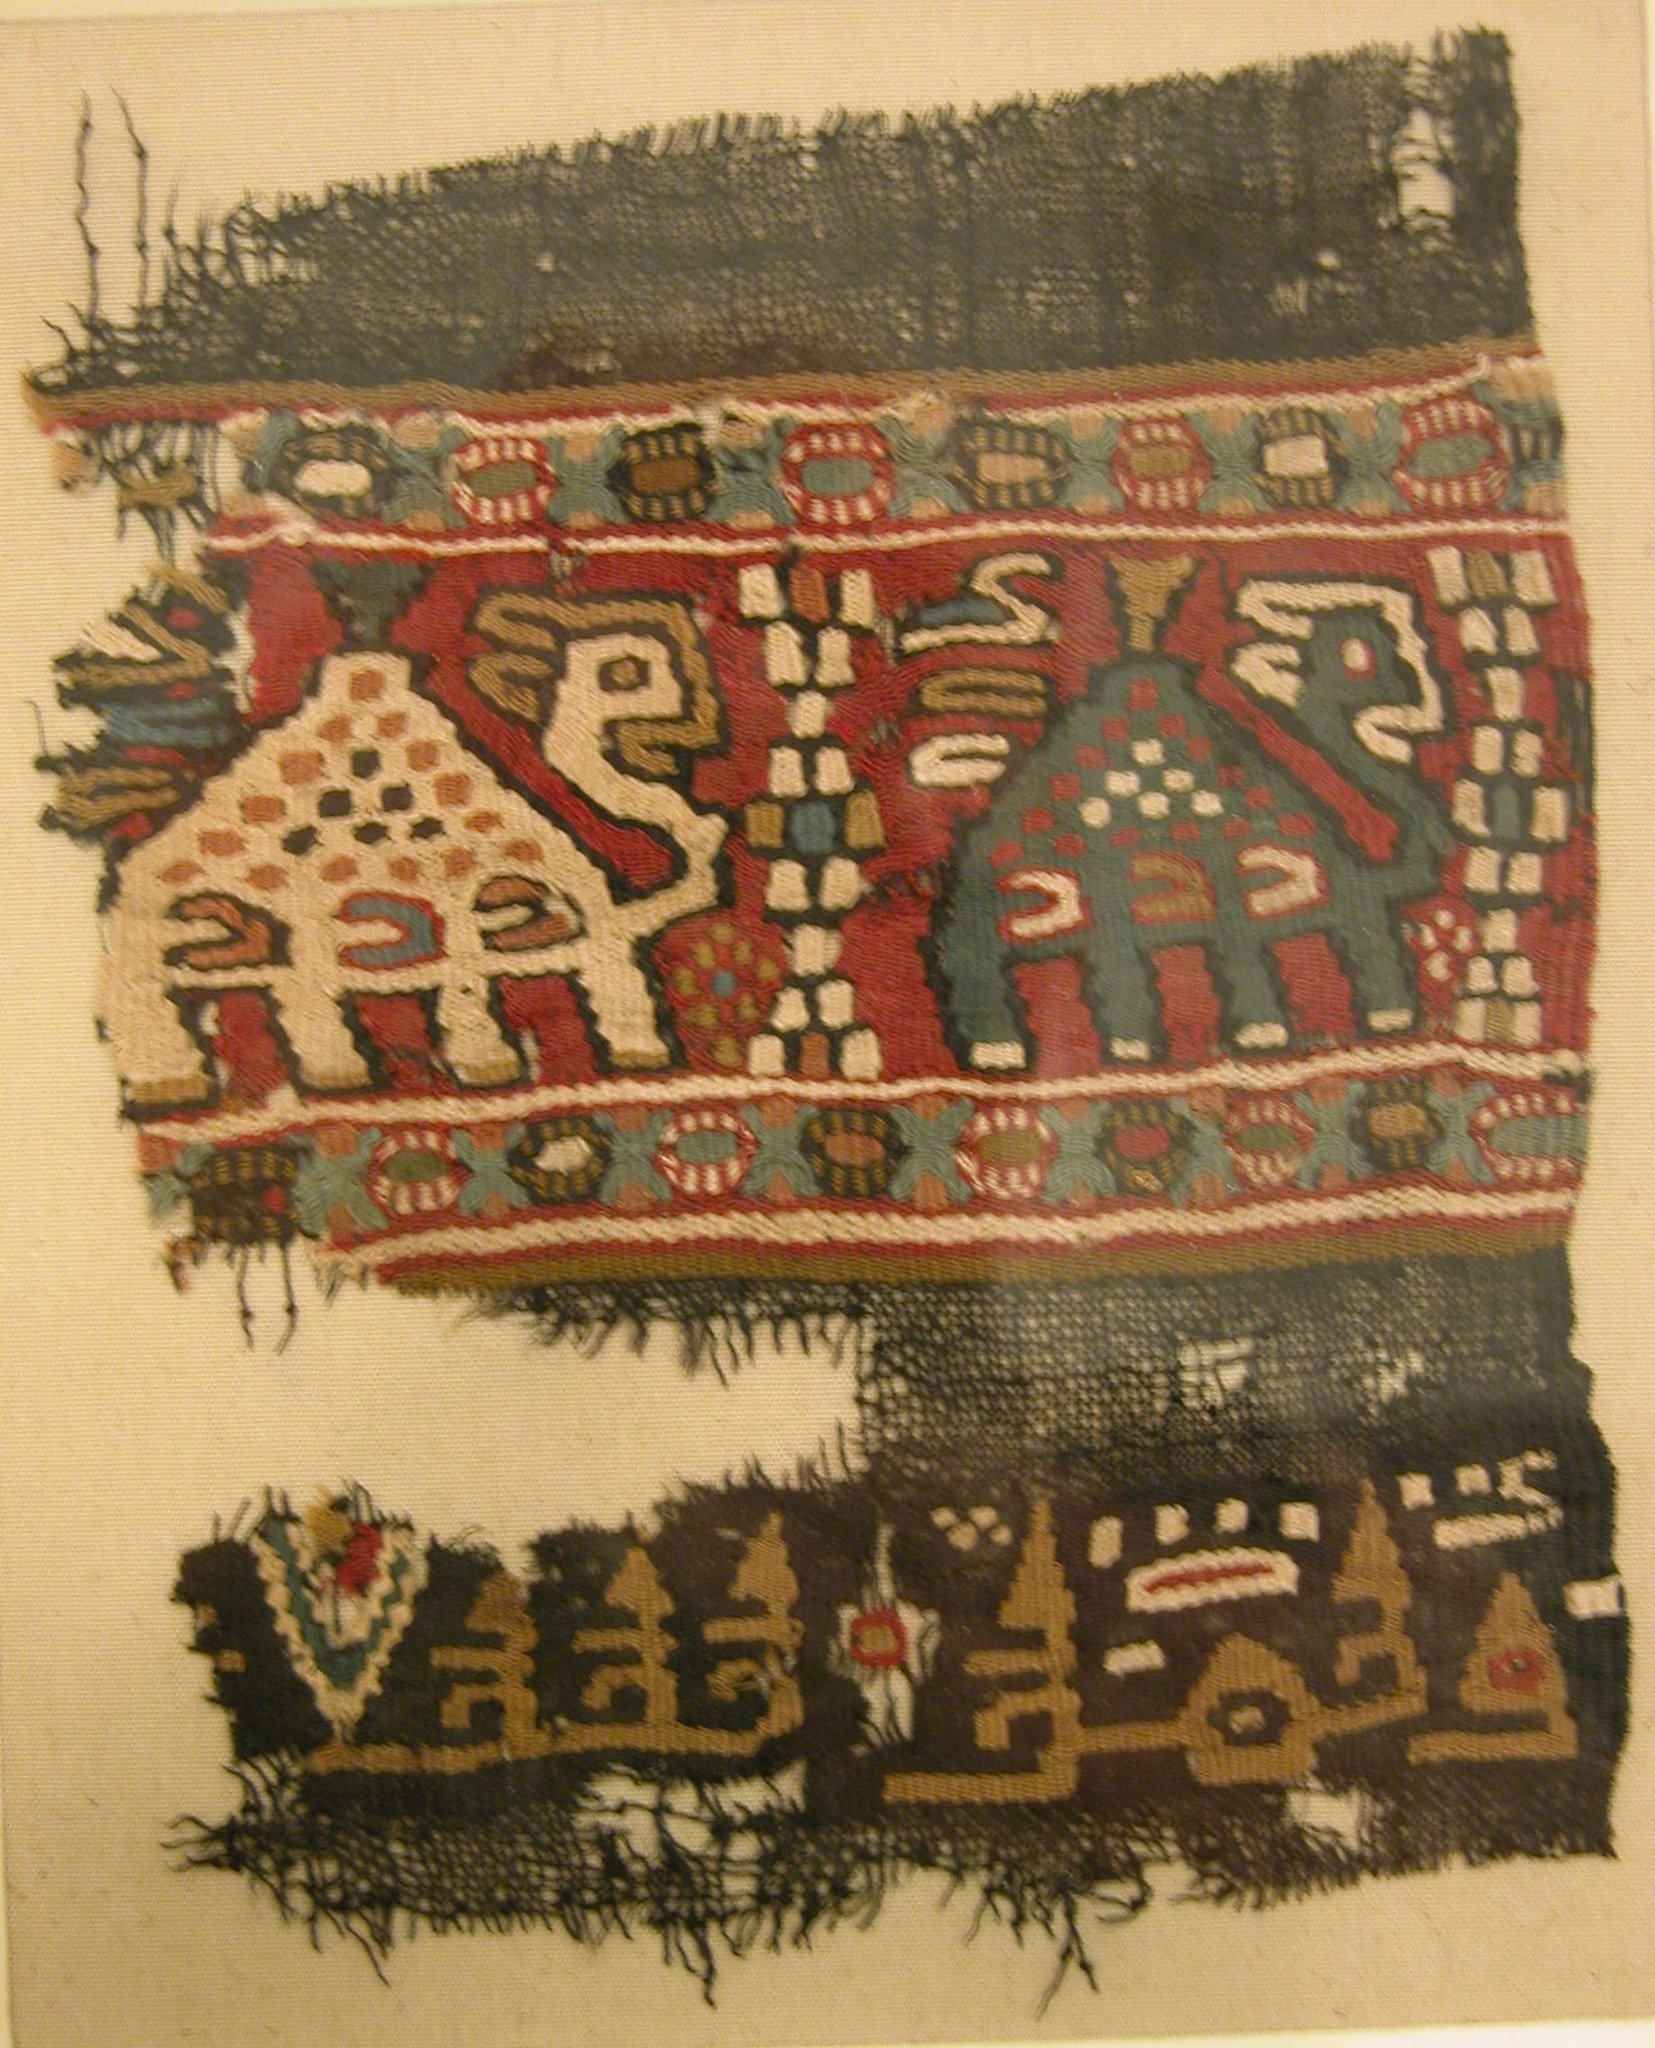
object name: textile fragment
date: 801-900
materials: wool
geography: egypt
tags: animals